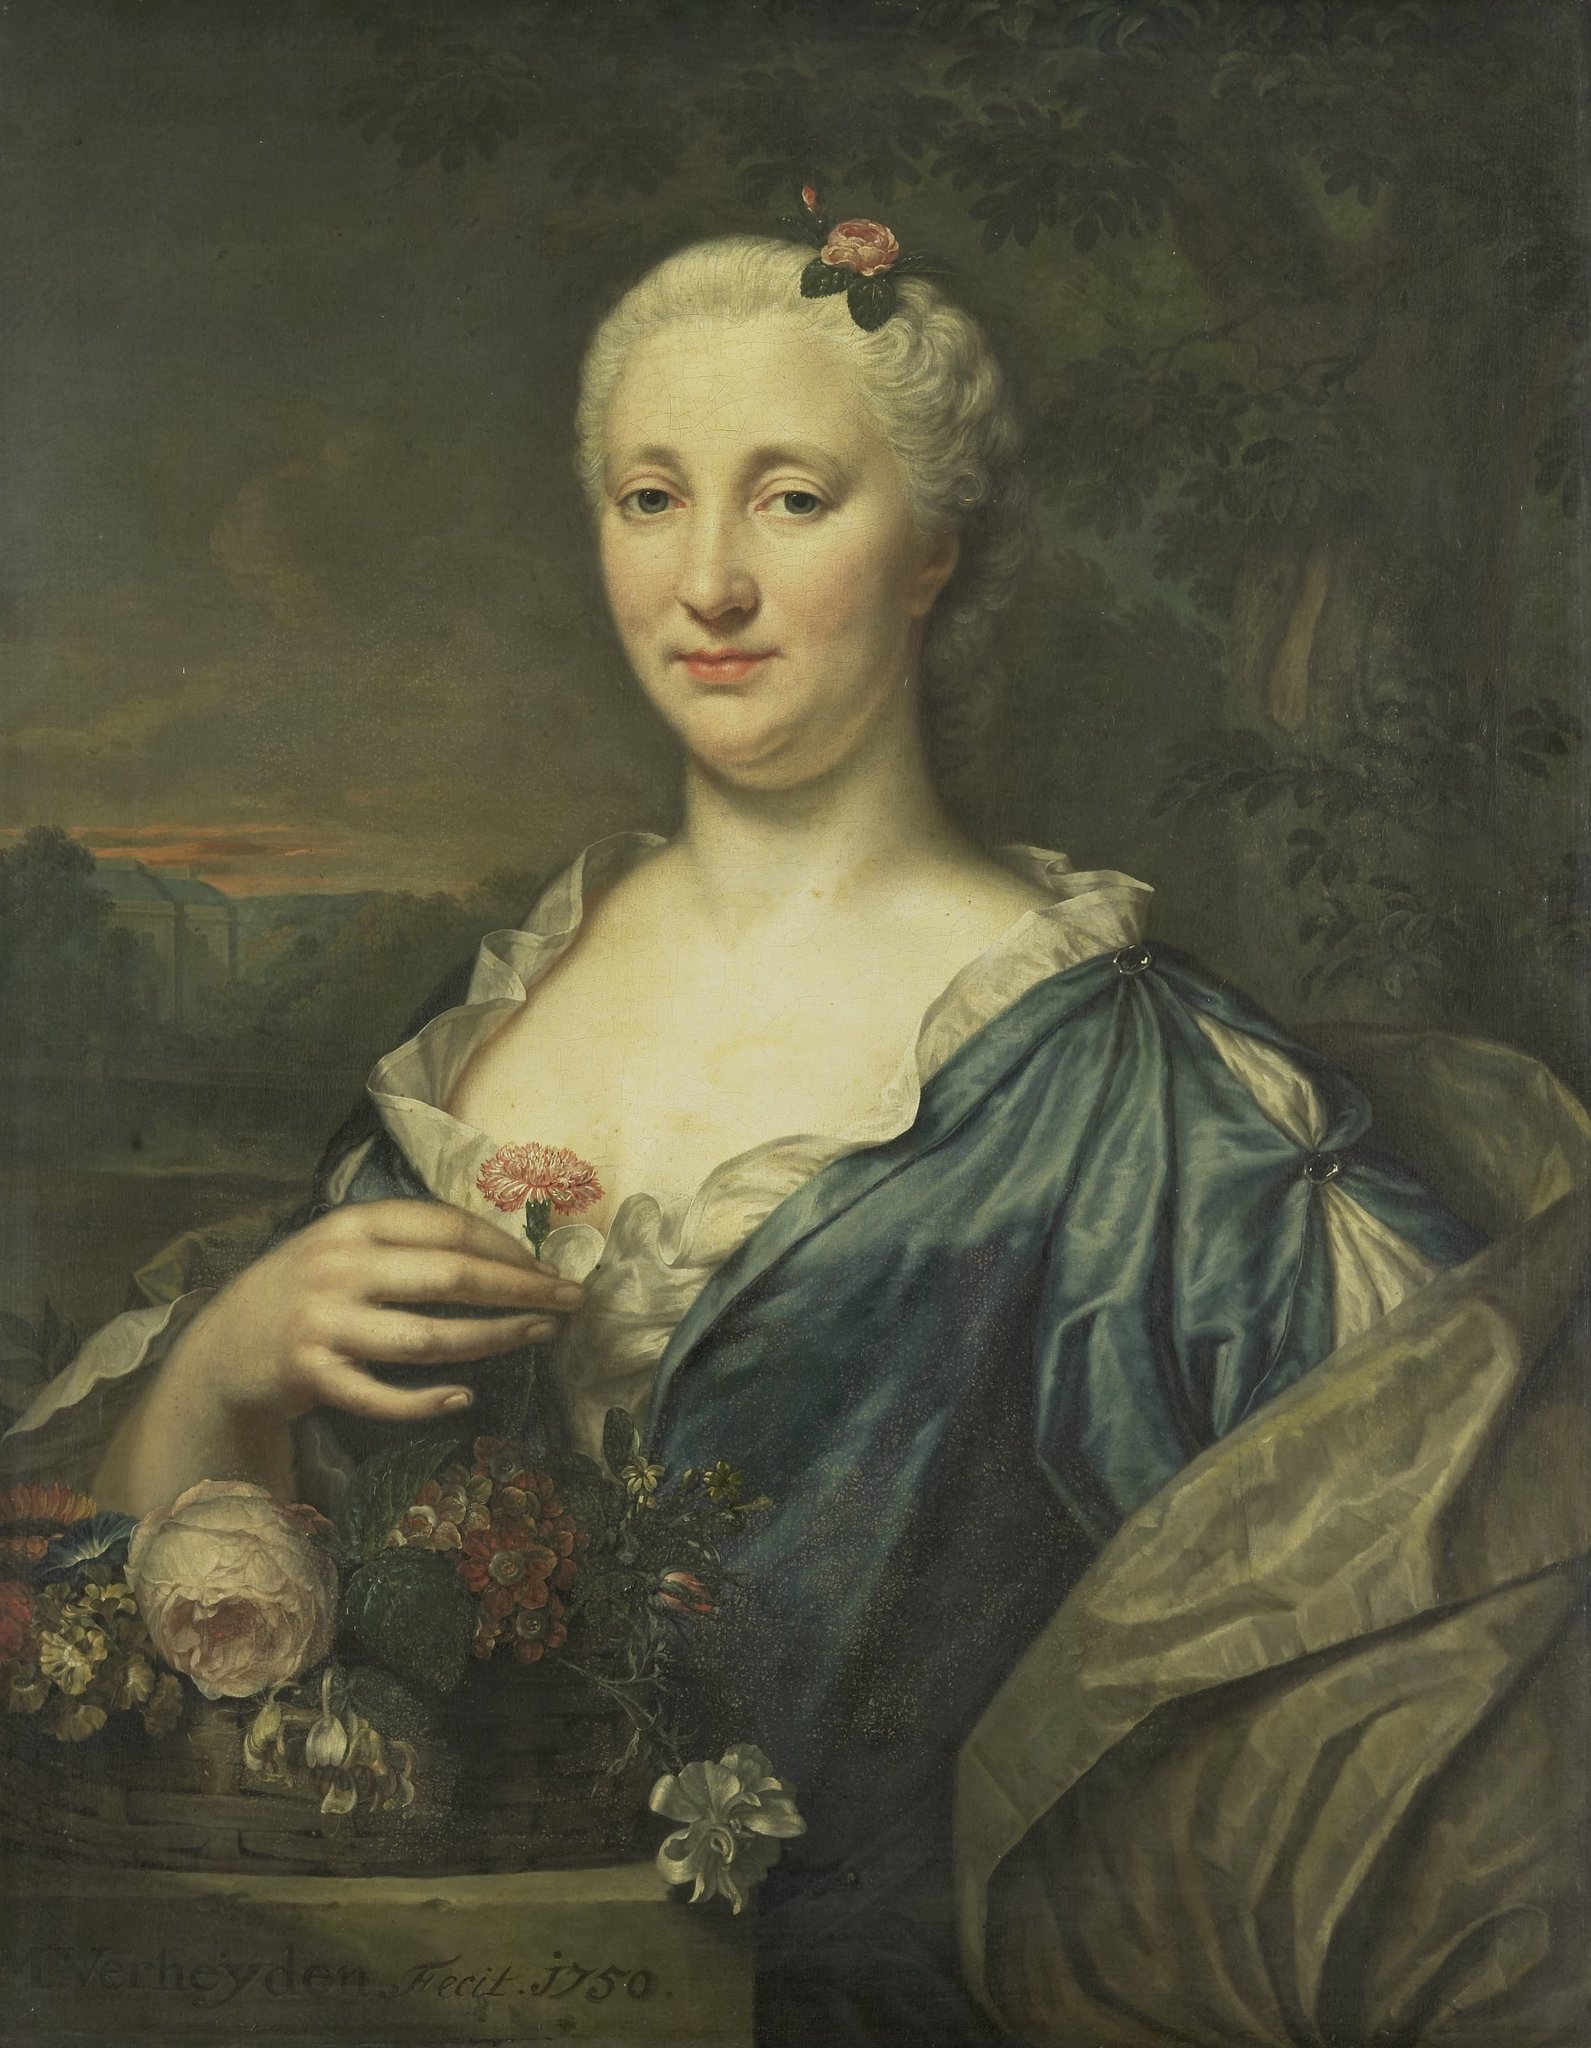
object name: painting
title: Portrait of Agnes Margaretha Albinus, Wife of Coenraad van Heemskerck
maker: mattheus verheyden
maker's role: draughtsman, painter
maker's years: 1700-1777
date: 1750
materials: canvas, oil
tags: historical persons - bb - woman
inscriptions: signature and date: ‘M. Verheijden Fecit 1750’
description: Portret van Agnes Margaretha Albinus (1713-73), echtgenote van Coenraad van Heemskerck. Ten halven lijve, bij een mand met een bloemstuk, een anjer in de rechterhand voor de borst. Pendant van SK-A-1438.